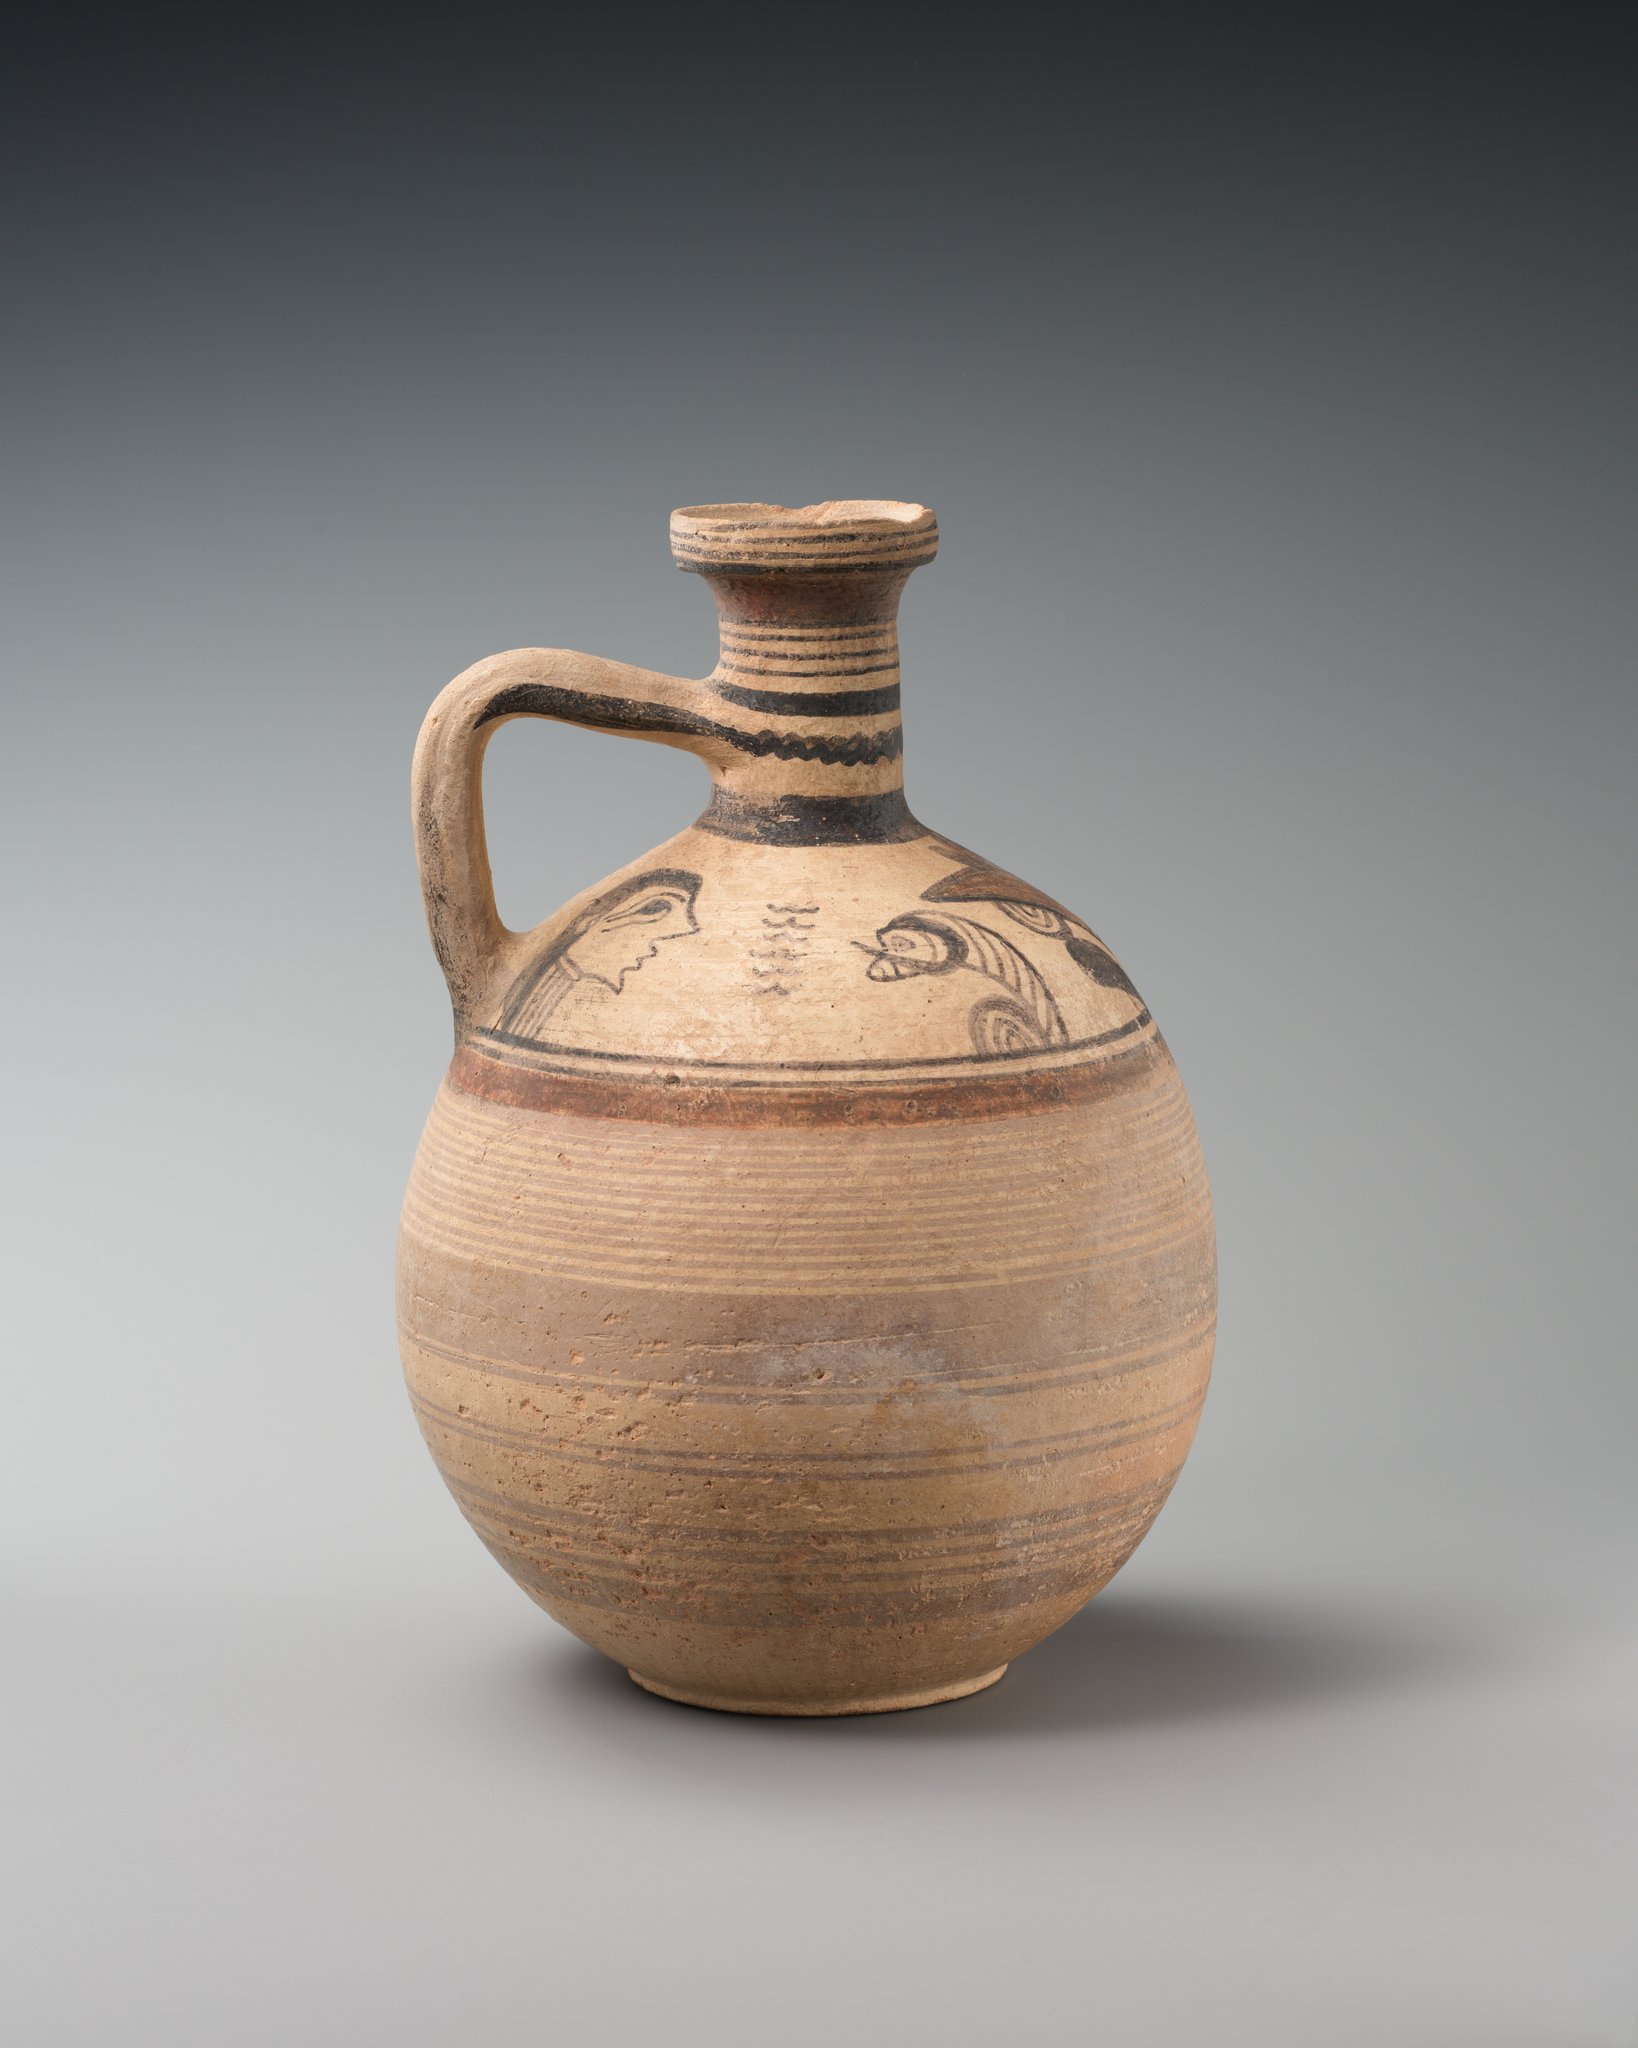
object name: jug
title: Terracotta jug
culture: cypriot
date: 750-600 BCE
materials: terracotta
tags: women,serpents